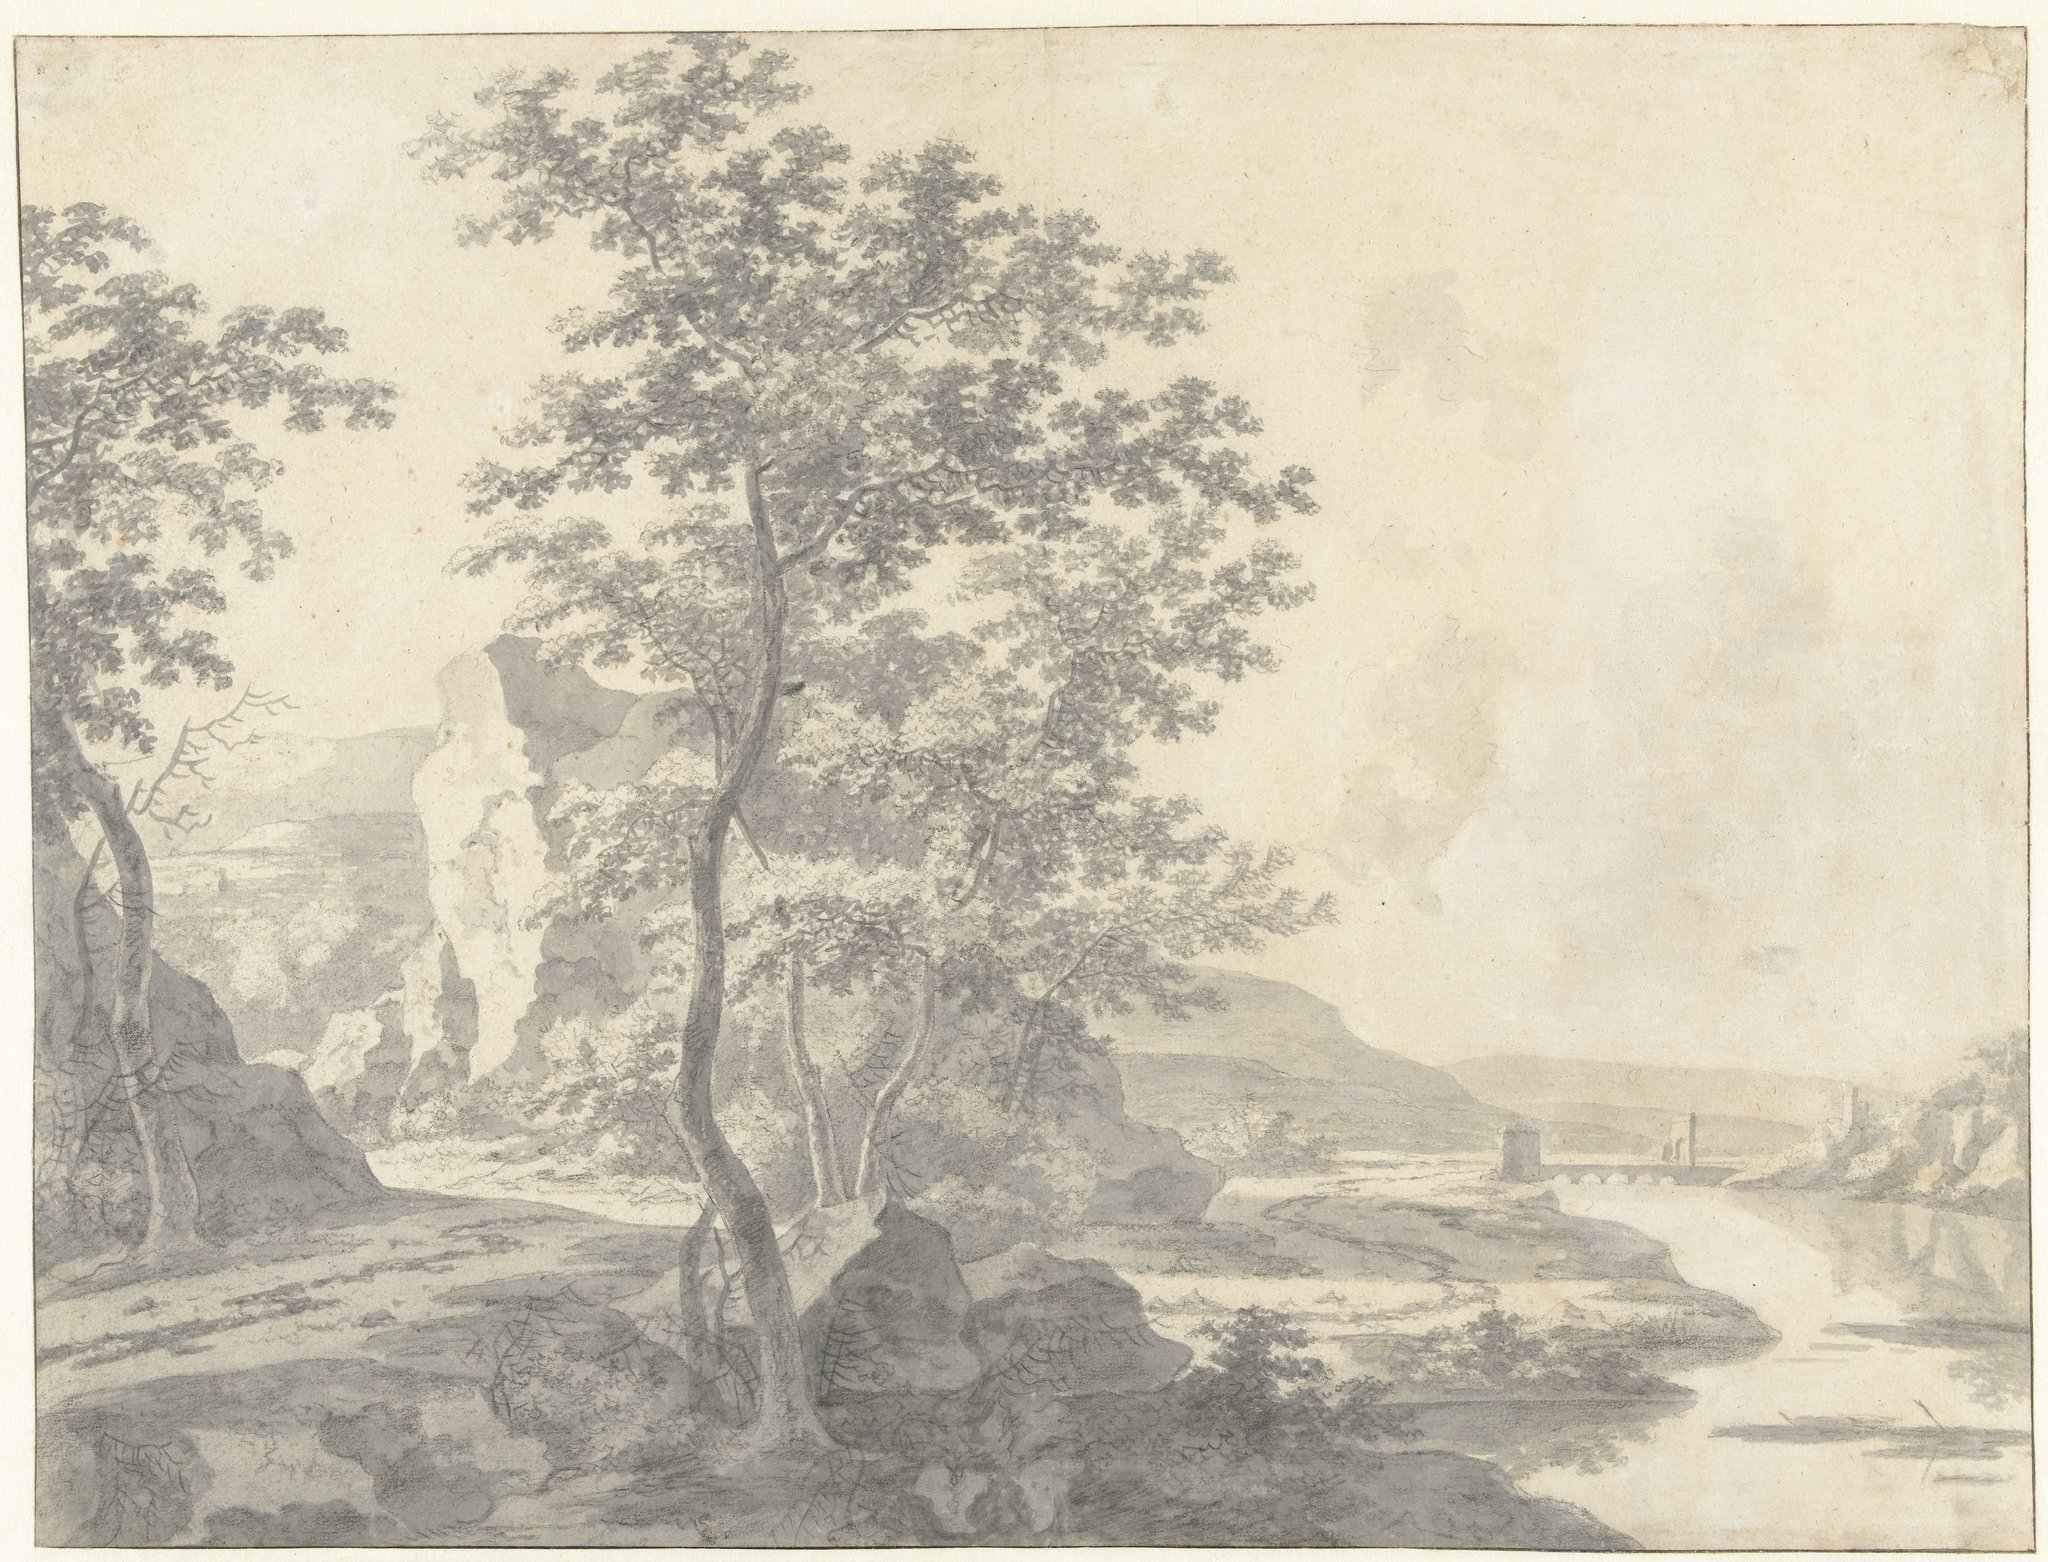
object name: drawing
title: Italiaans landschap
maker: jan both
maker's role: draughtsman, painter, print maker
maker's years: 1618-1652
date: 1628-1652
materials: chalk, paper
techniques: brush